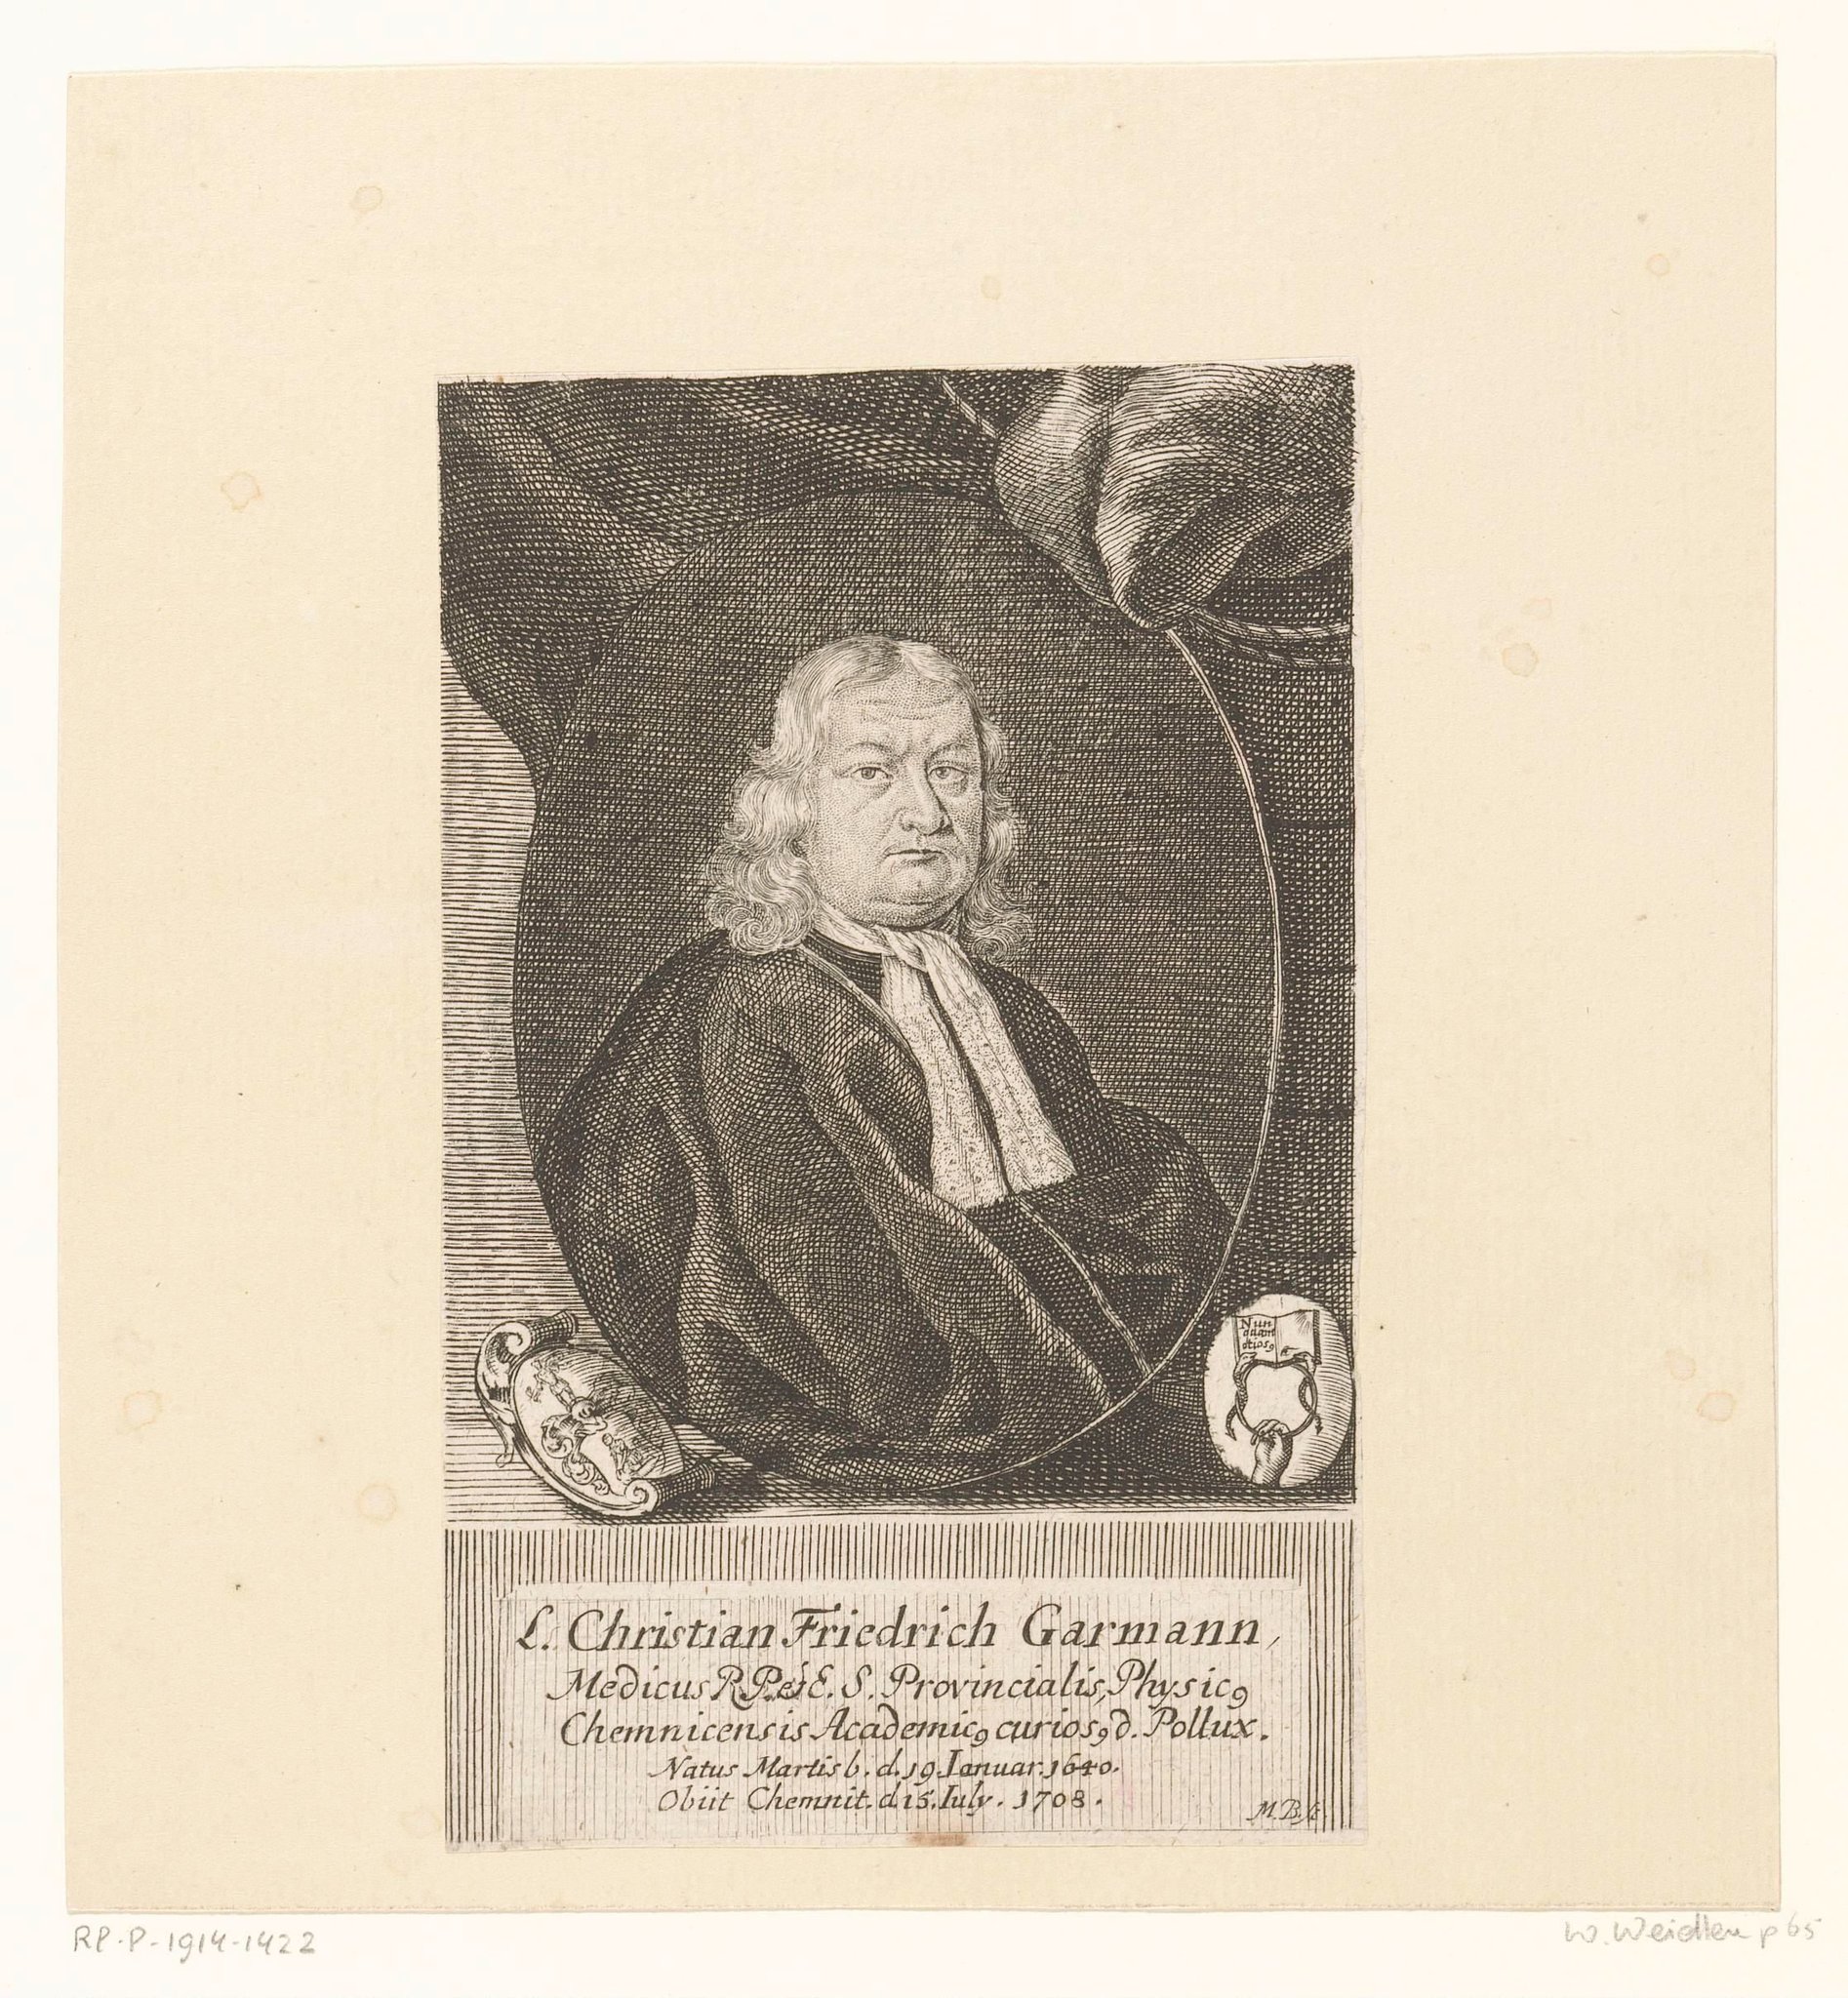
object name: print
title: Portret van Christian Friedrich Garmann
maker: martin bernigeroth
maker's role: print maker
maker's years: 1670-1733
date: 1708-1733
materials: paper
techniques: engraving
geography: leipzig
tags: chemnitz, historical persons, armorial bearing, heraldry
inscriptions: collector's mark: Lugt 2228